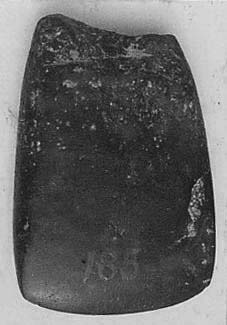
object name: hatchet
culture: swiss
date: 1902